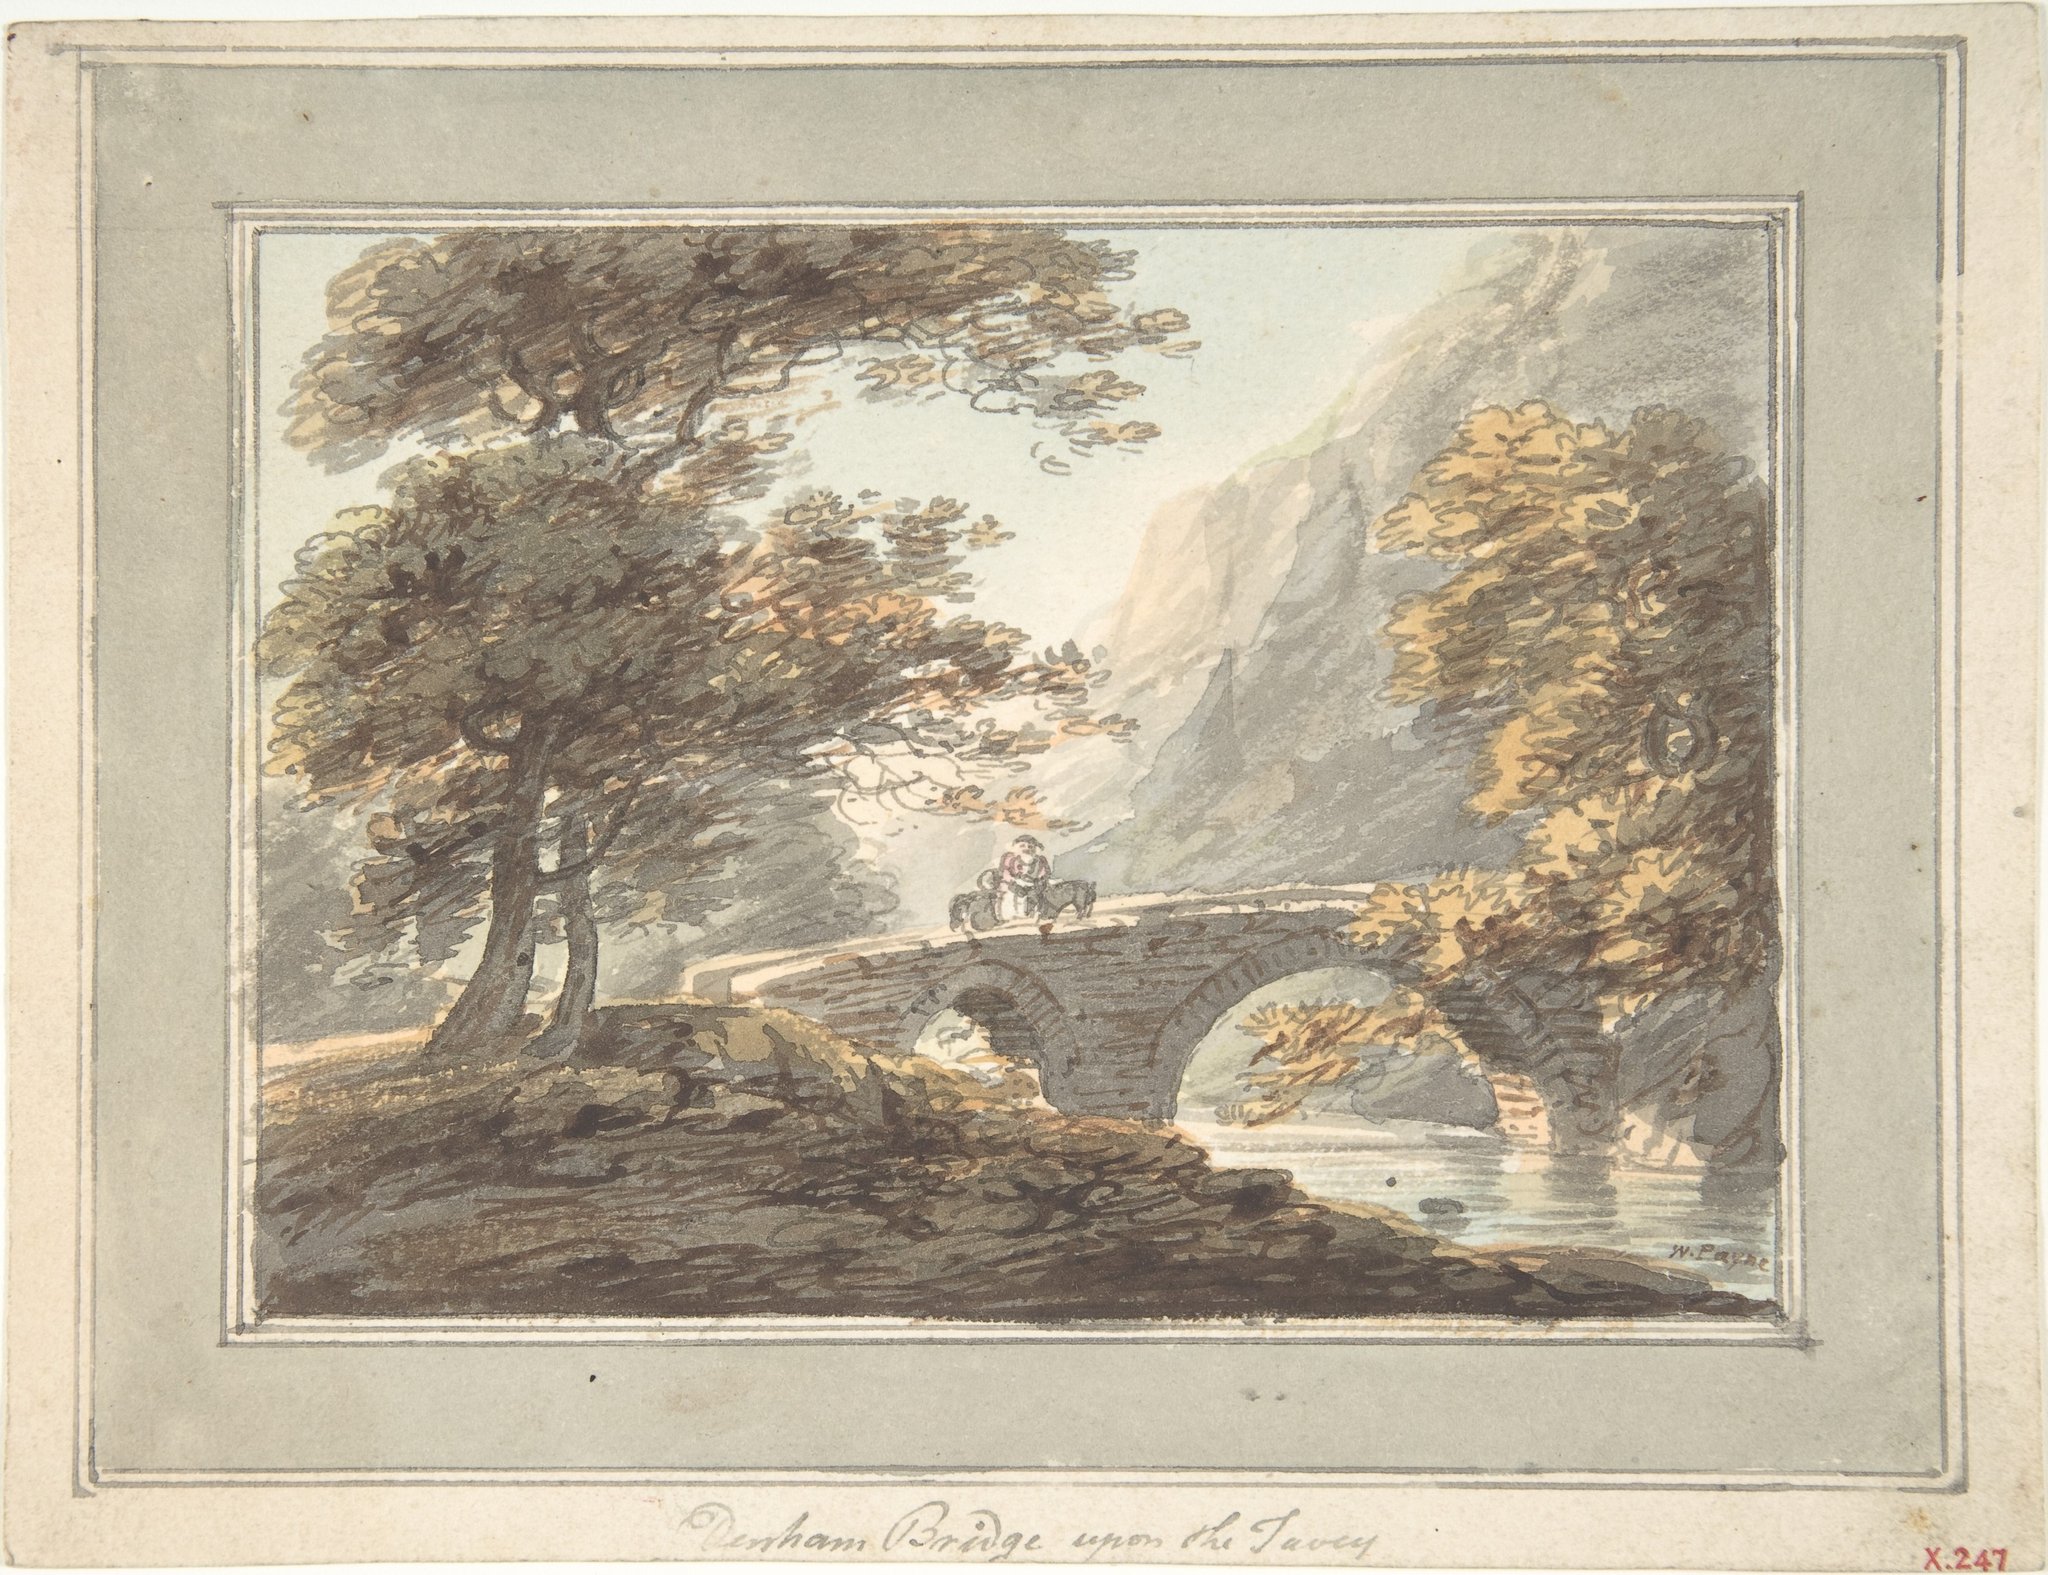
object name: drawing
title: Denham Bridge upon the Tavy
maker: william payne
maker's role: artist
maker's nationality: british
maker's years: 1760-1830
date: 1780-1830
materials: watercolor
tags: bridges,men,mountains,trees